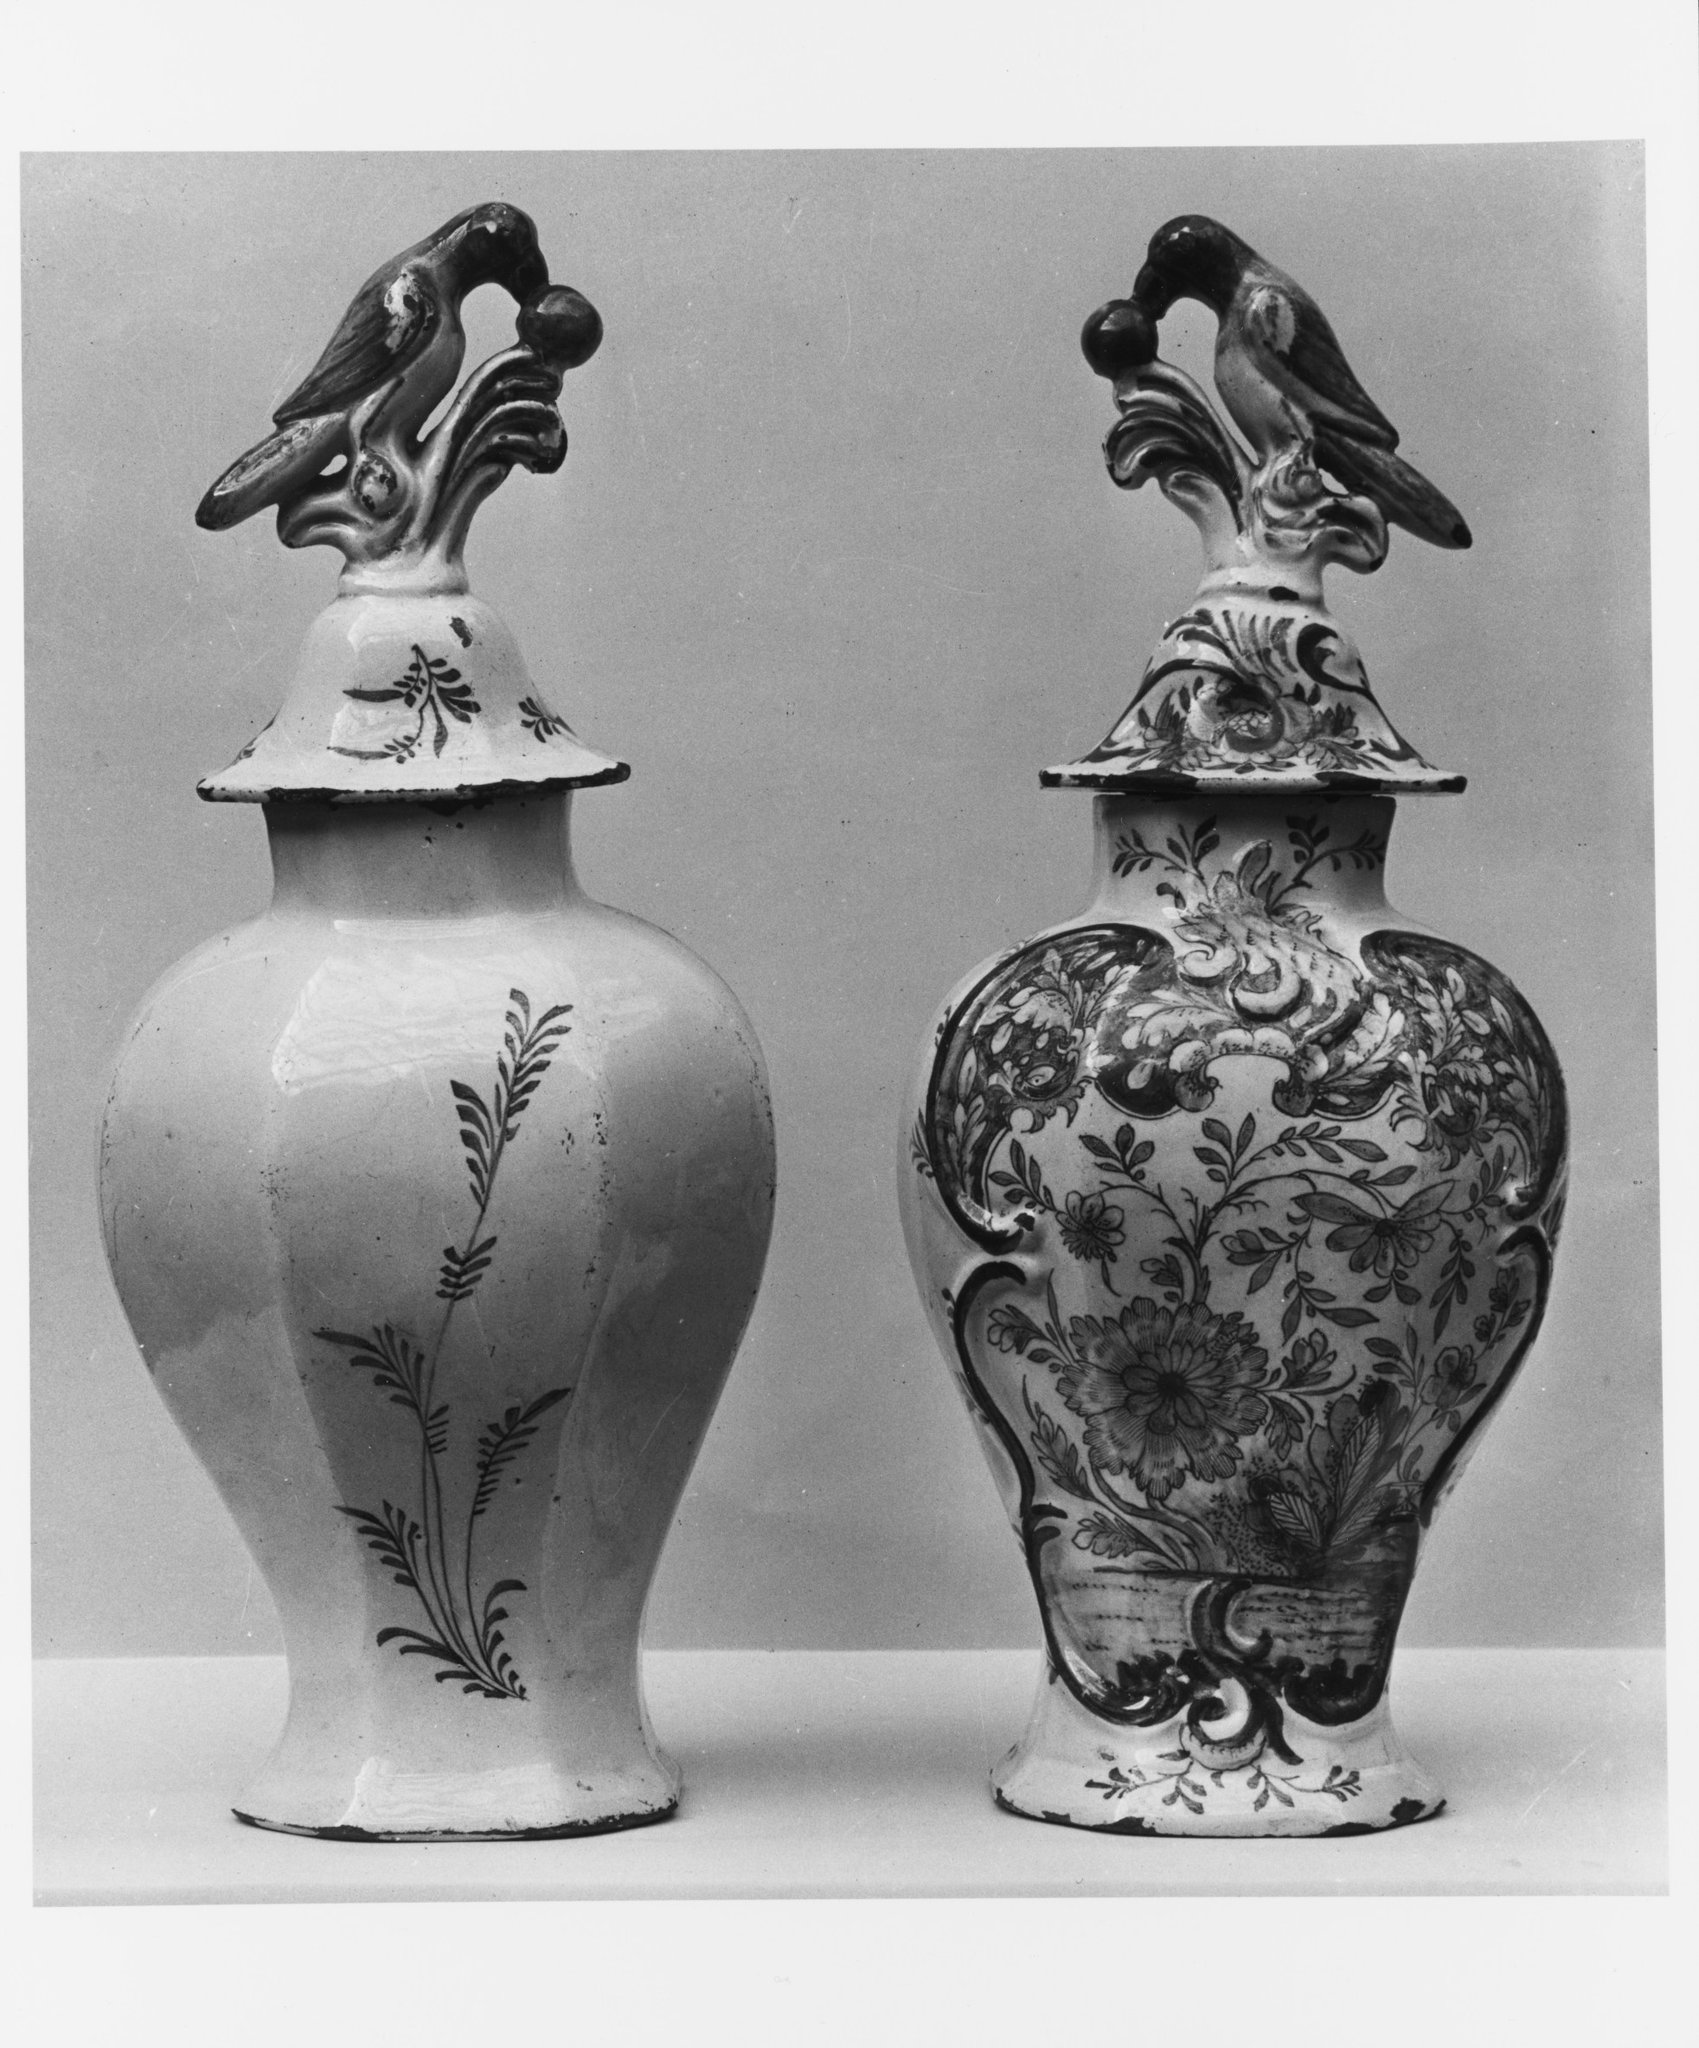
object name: jar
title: Covered Jar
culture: dutch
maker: justus brouwer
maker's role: designer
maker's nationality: dutch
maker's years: 1739-1775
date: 1739-1775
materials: earthenware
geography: netherlands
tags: birds,flowers